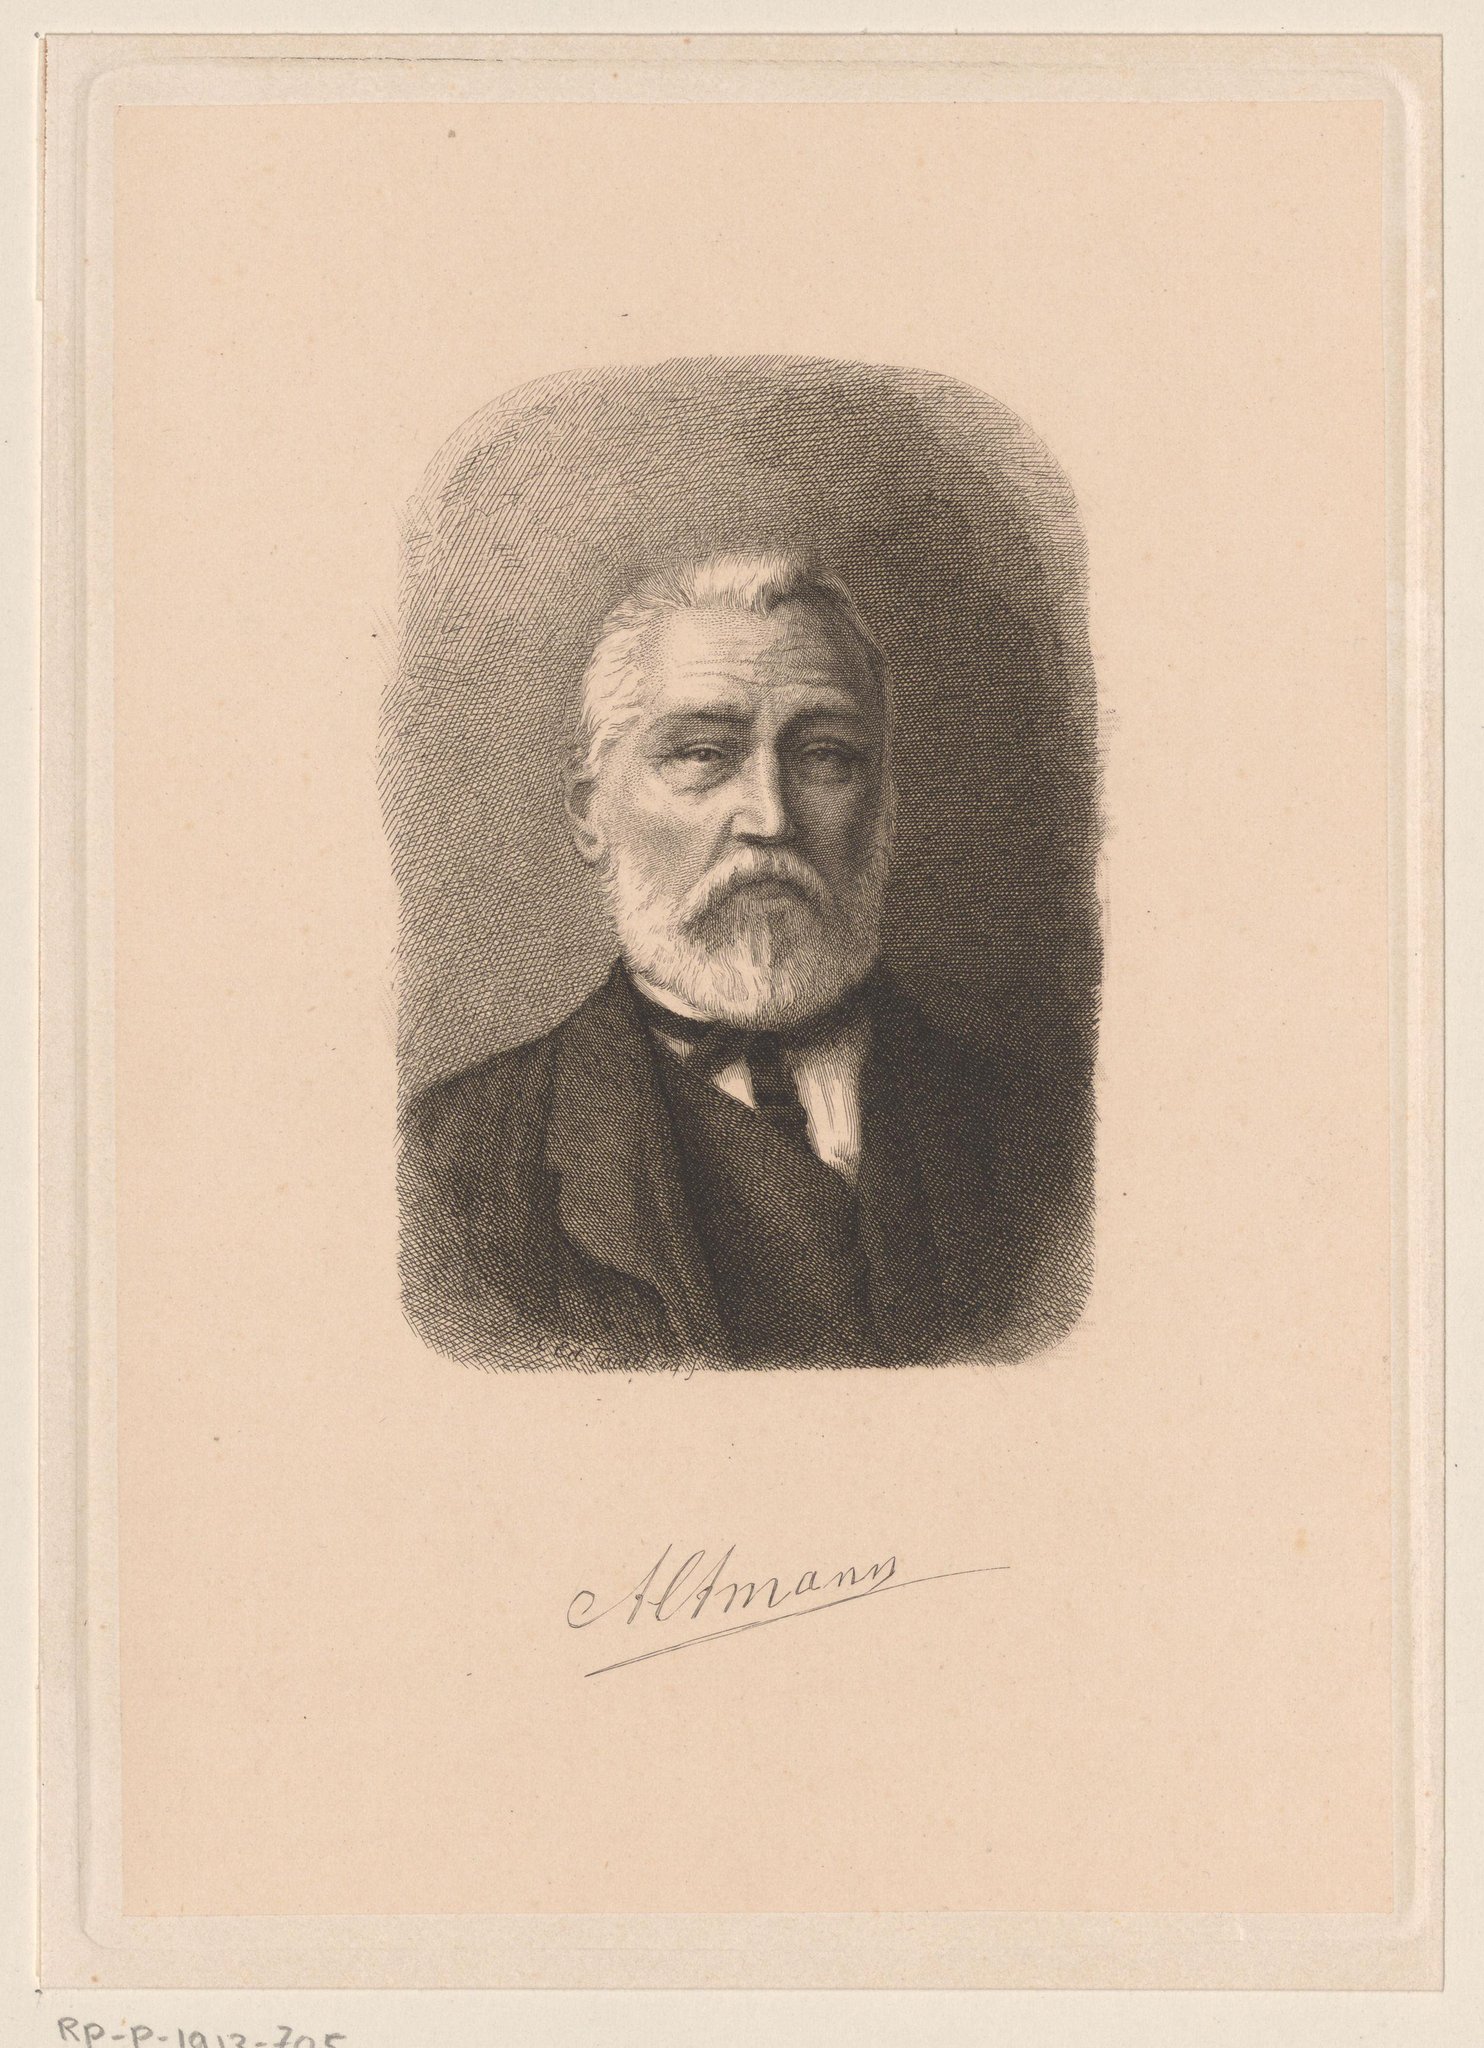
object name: print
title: Portret van Sybrand Altmann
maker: edouard taurel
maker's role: draughtsman, print maker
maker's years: 1824-1892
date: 1870-1892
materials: paper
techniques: etching, roulette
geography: amsterdam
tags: amsterdam, print maker, s. altmann, historical persons, portrait, self-portrait of painter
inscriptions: collector's mark: Lugt 2233